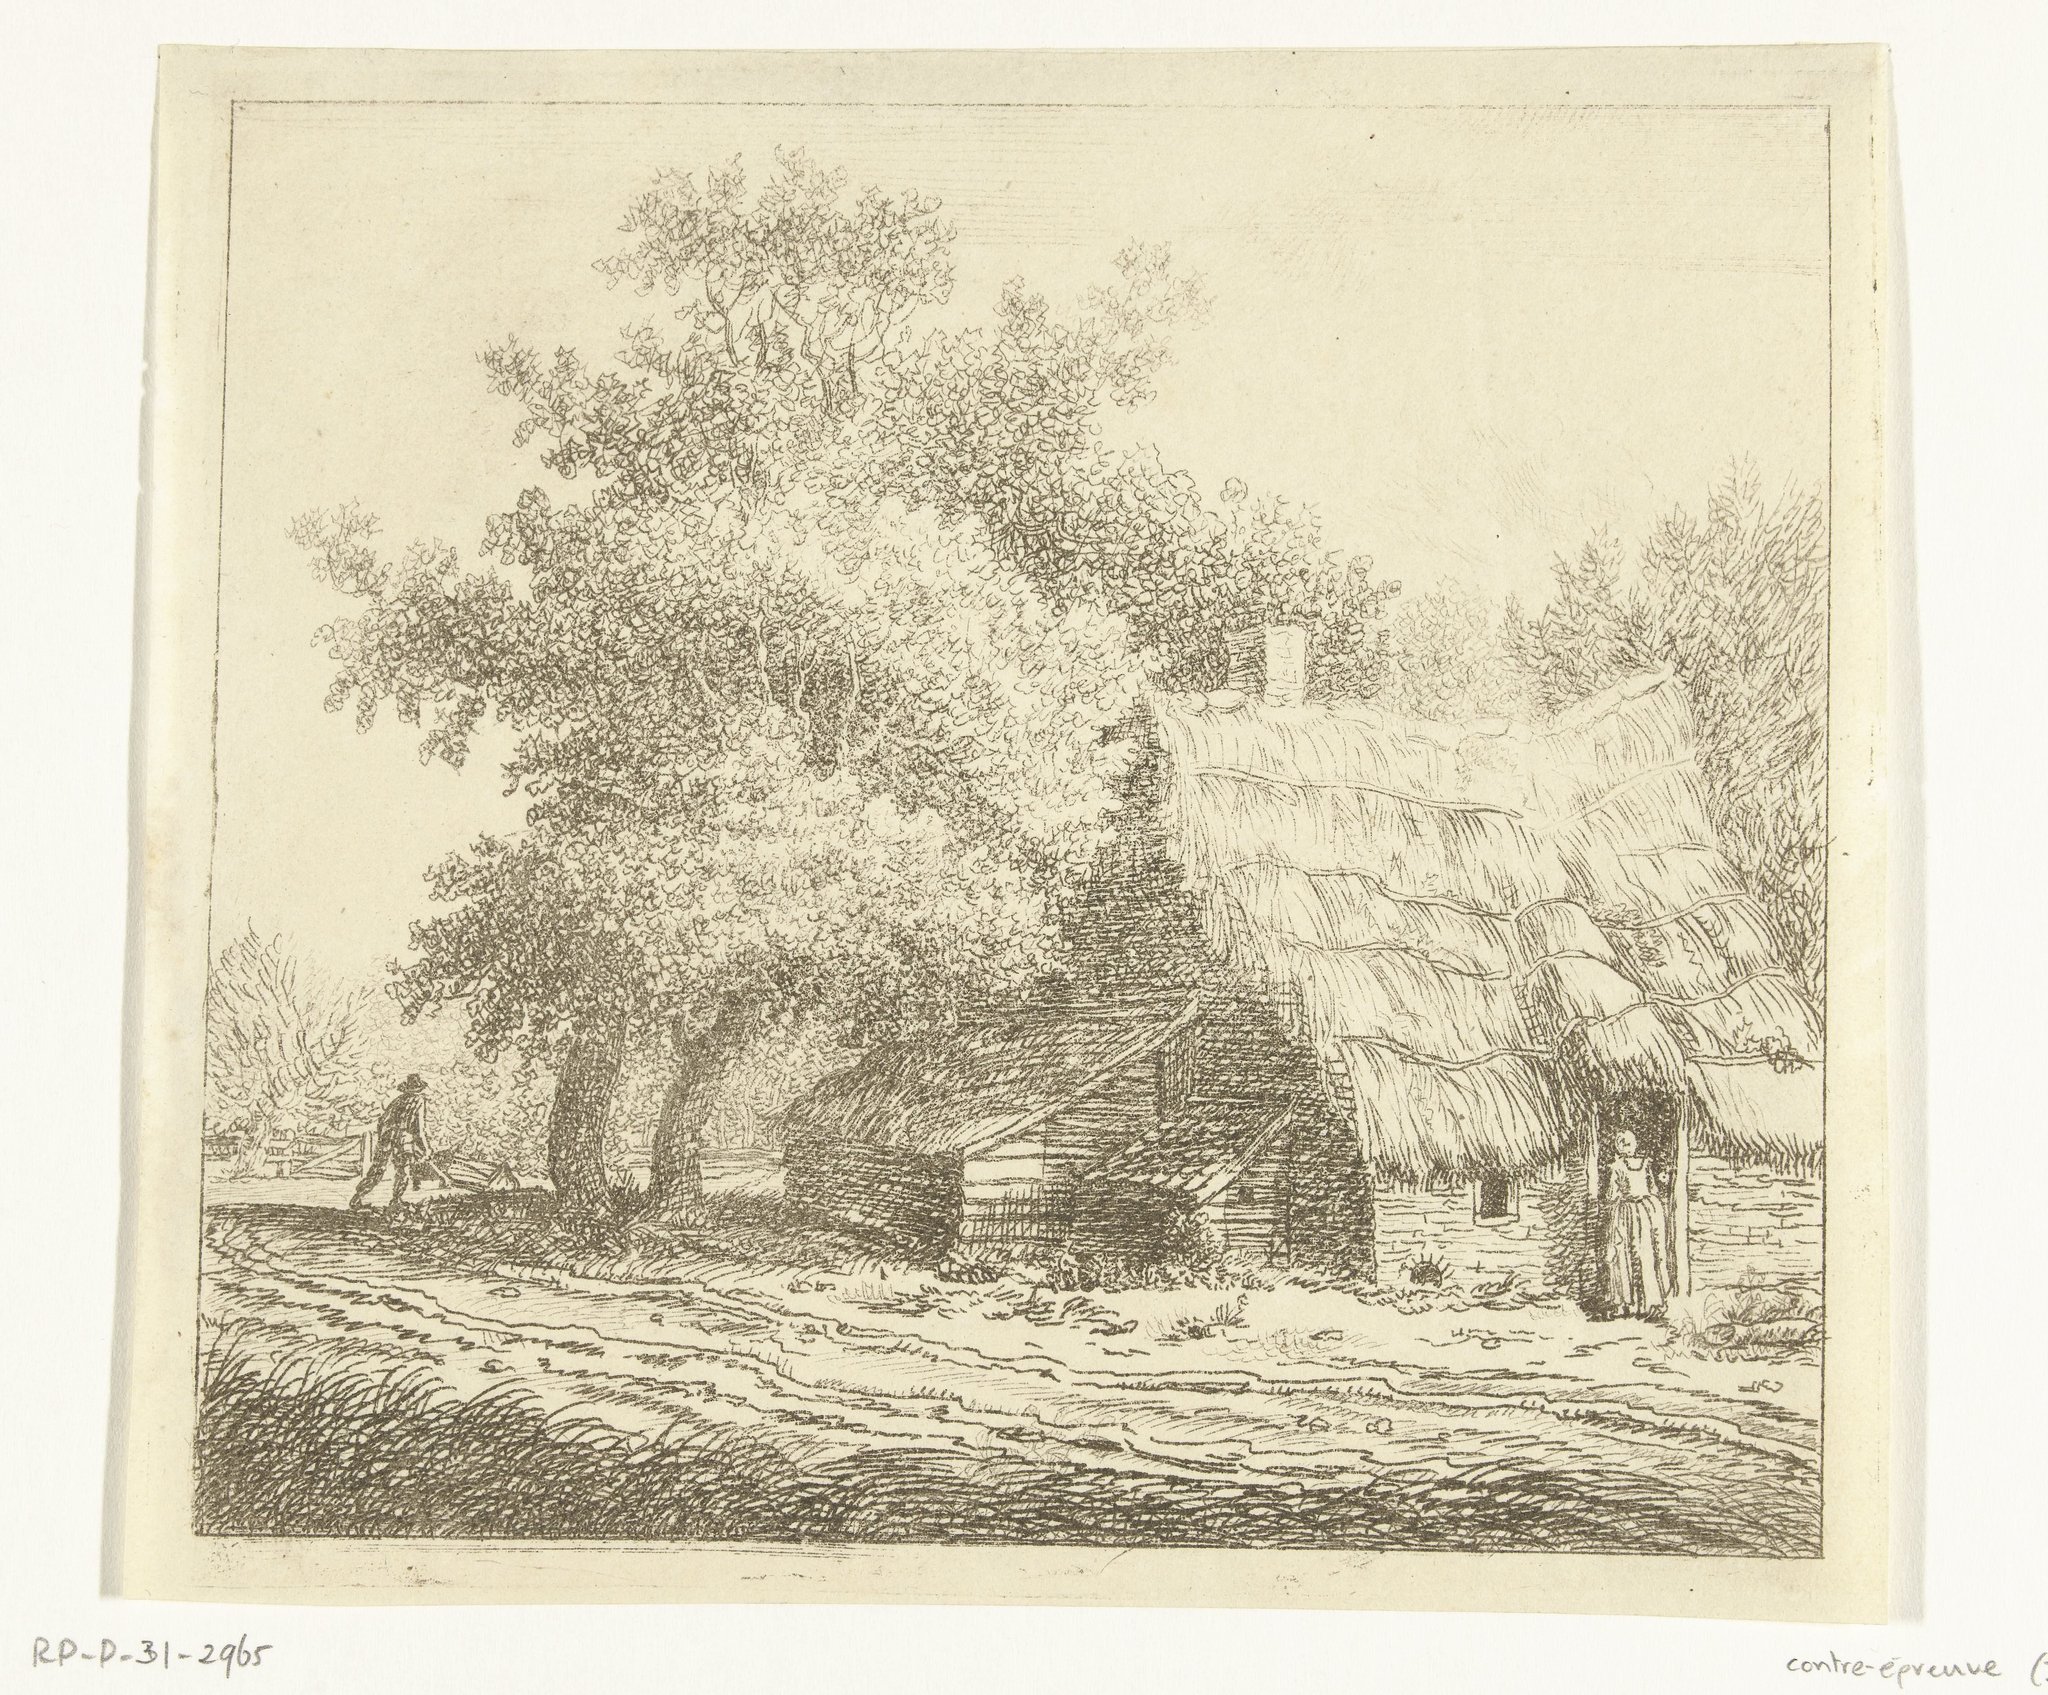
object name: print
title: Boerderij met vrouw bij de deur en een man met kruiwagen op een pad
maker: anthonie van den bos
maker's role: draughtsman, print maker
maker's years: 1763-1838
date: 1778-1838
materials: paper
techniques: printmaking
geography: netherlands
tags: farm or solitary house in landscape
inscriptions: collector's mark: Lugt 2228